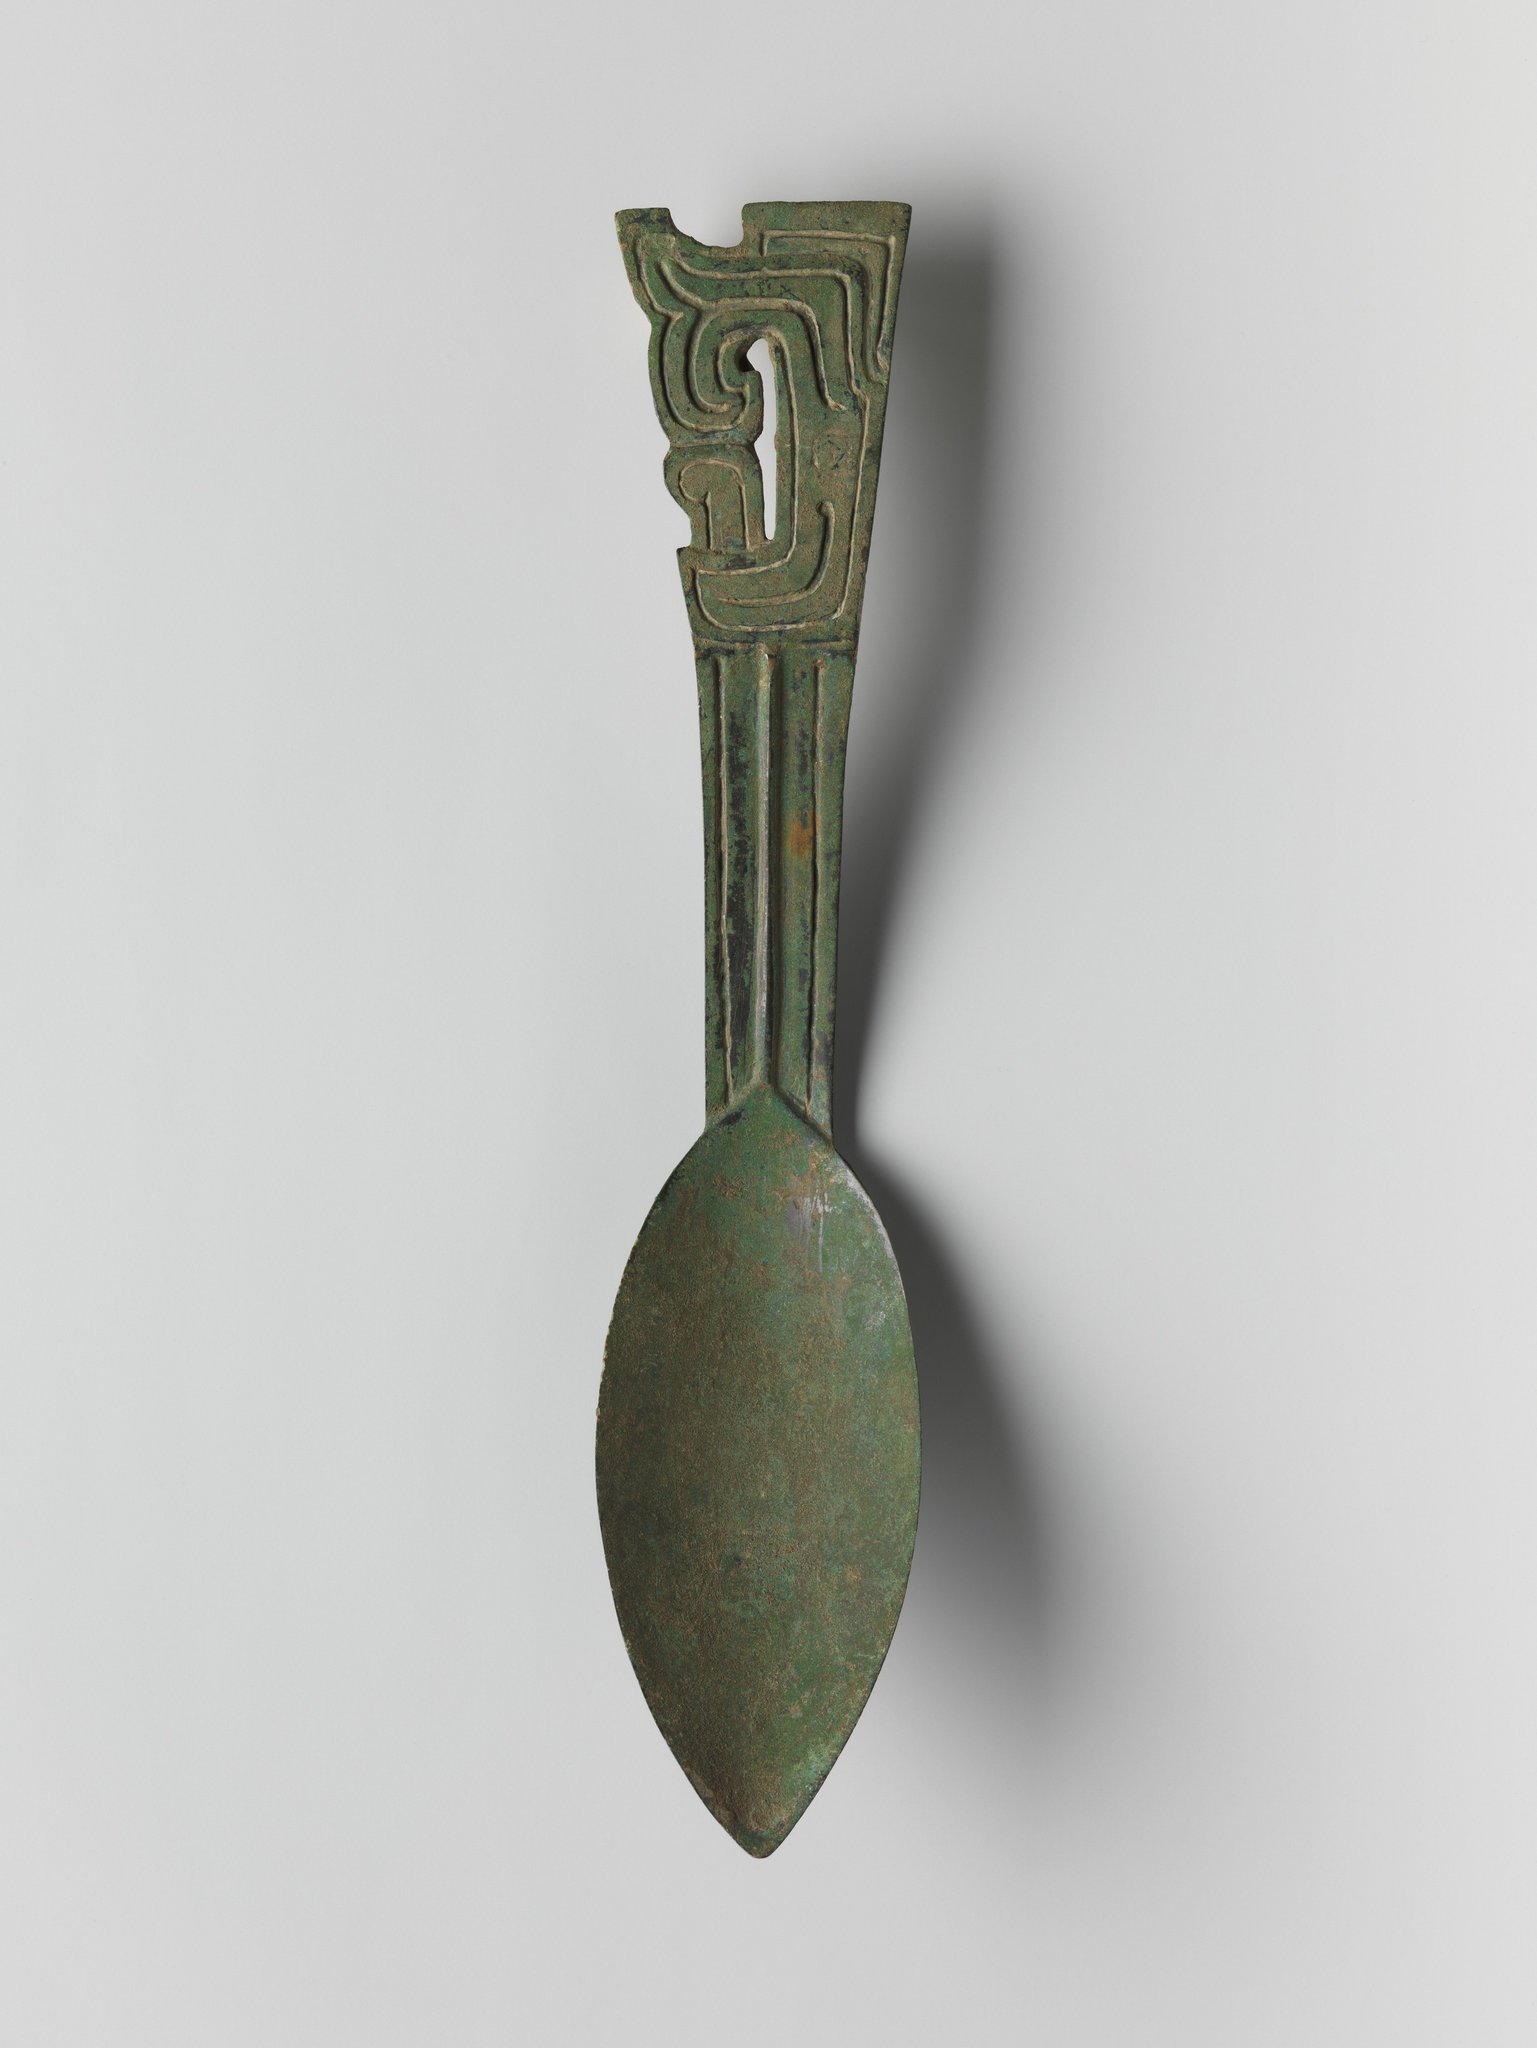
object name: spoon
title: Ritual Spoon (Bi)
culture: chinese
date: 1046-256 BCE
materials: bronze